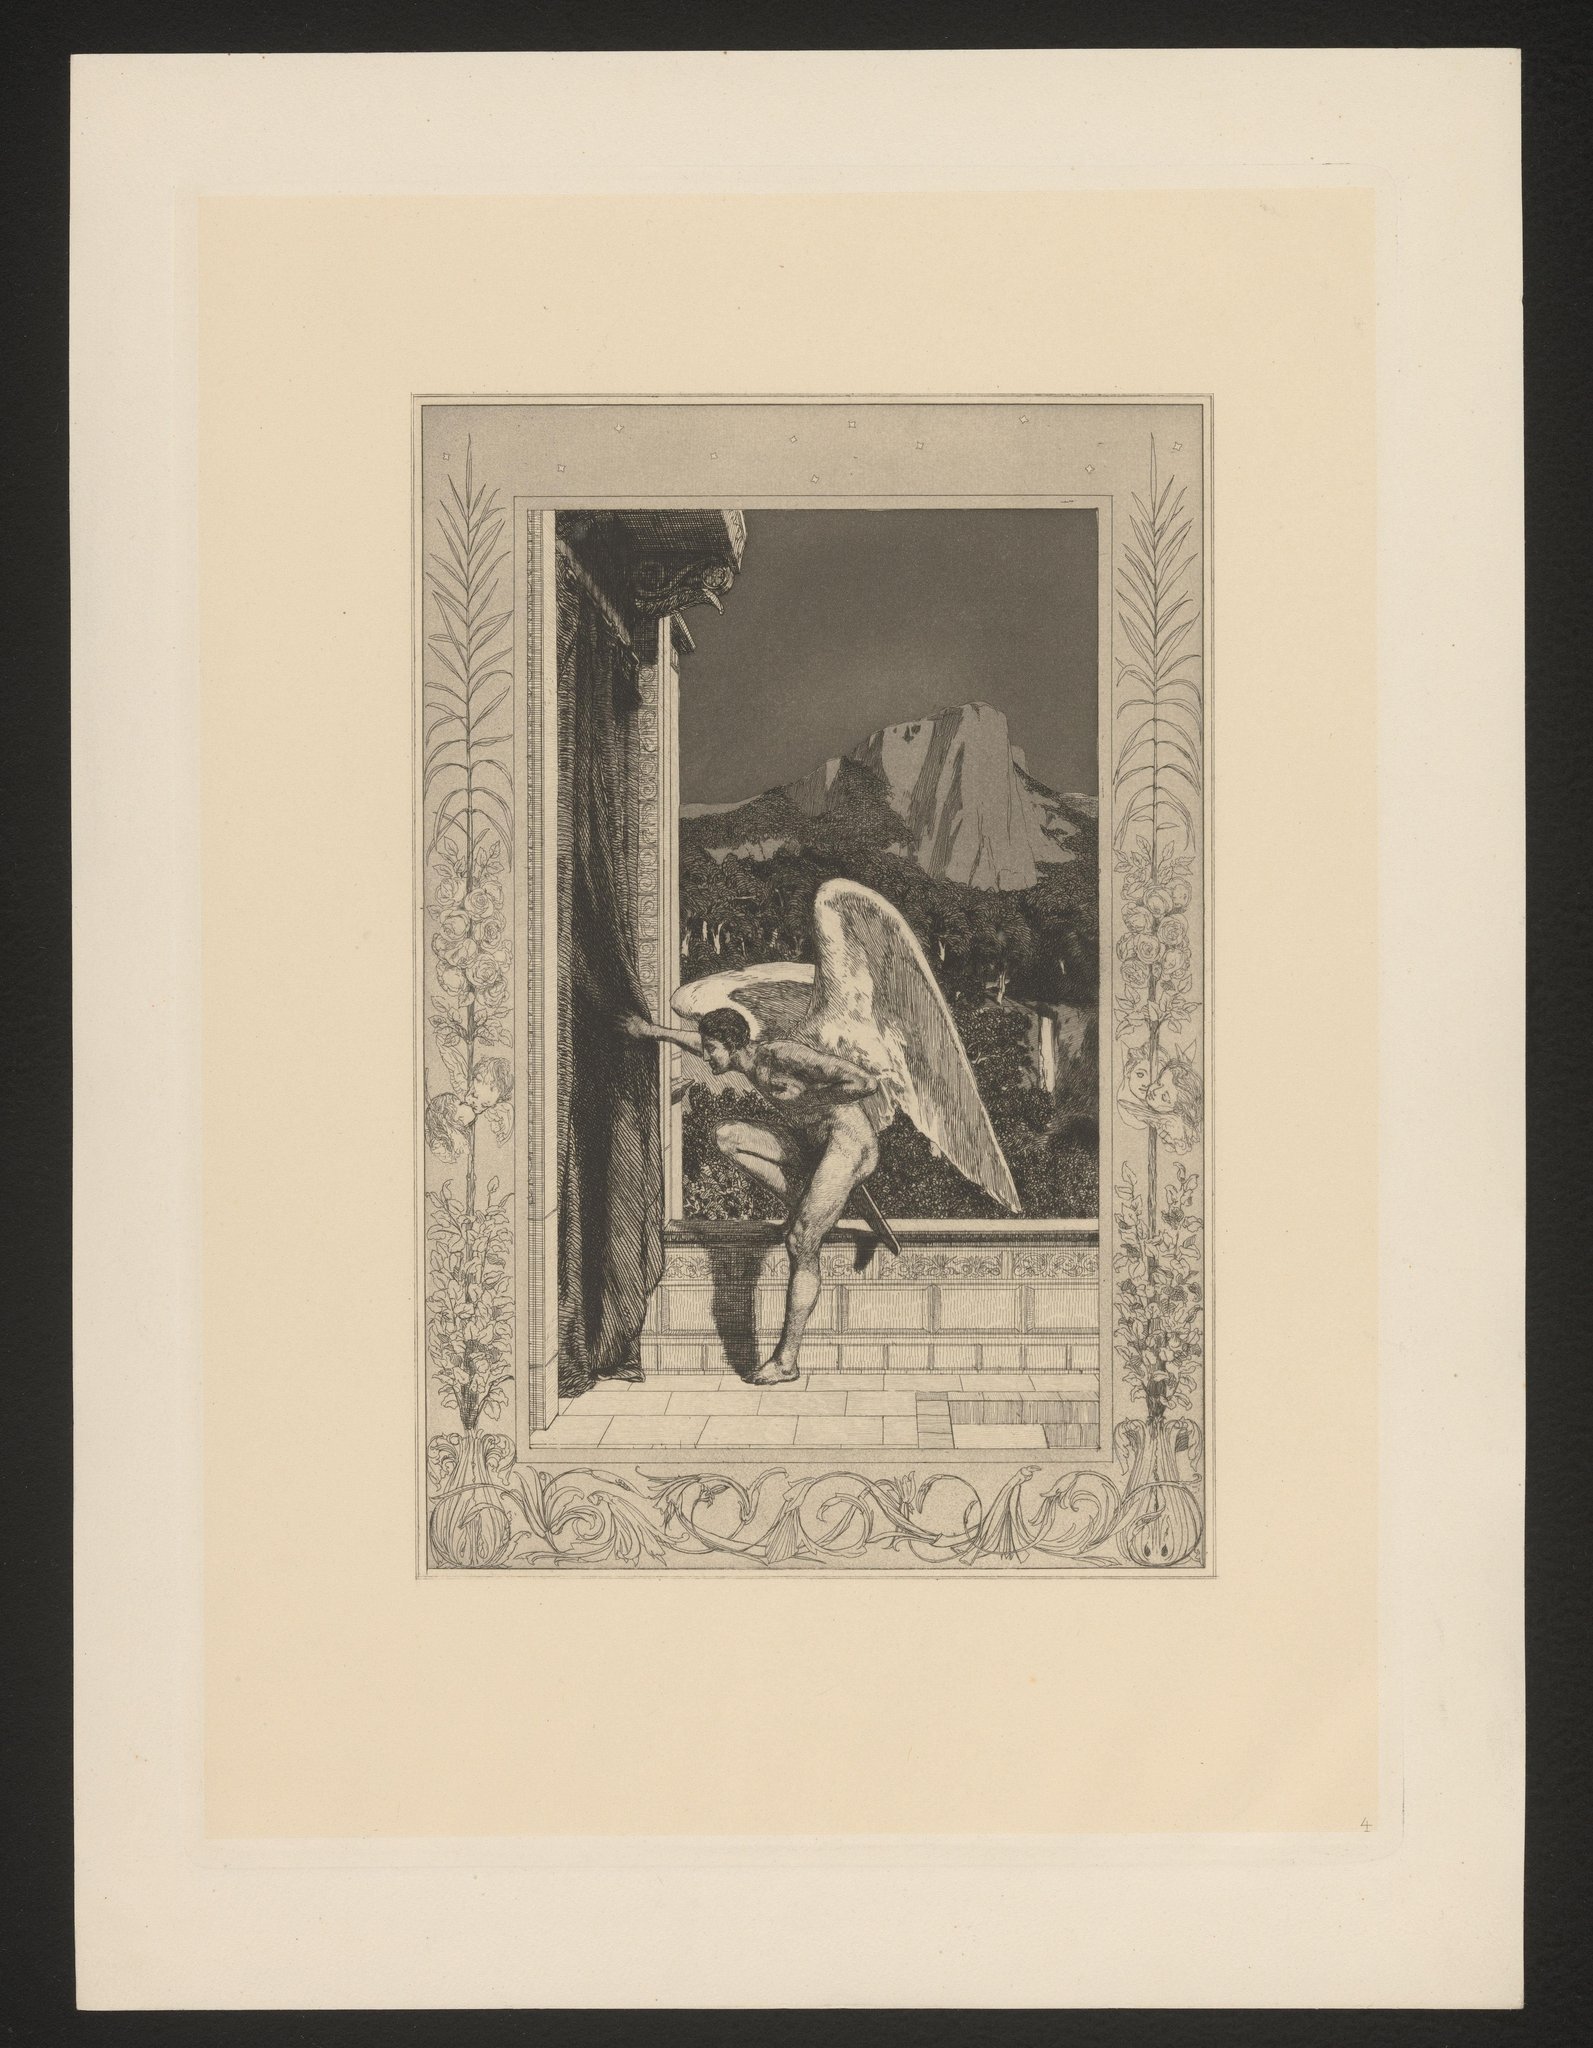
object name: print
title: Amor landt op een balkon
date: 1880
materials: paper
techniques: aquatint, etching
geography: nuremberg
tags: other scenes from the story of cupid and psyche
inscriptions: collector's mark: Lugt 2228